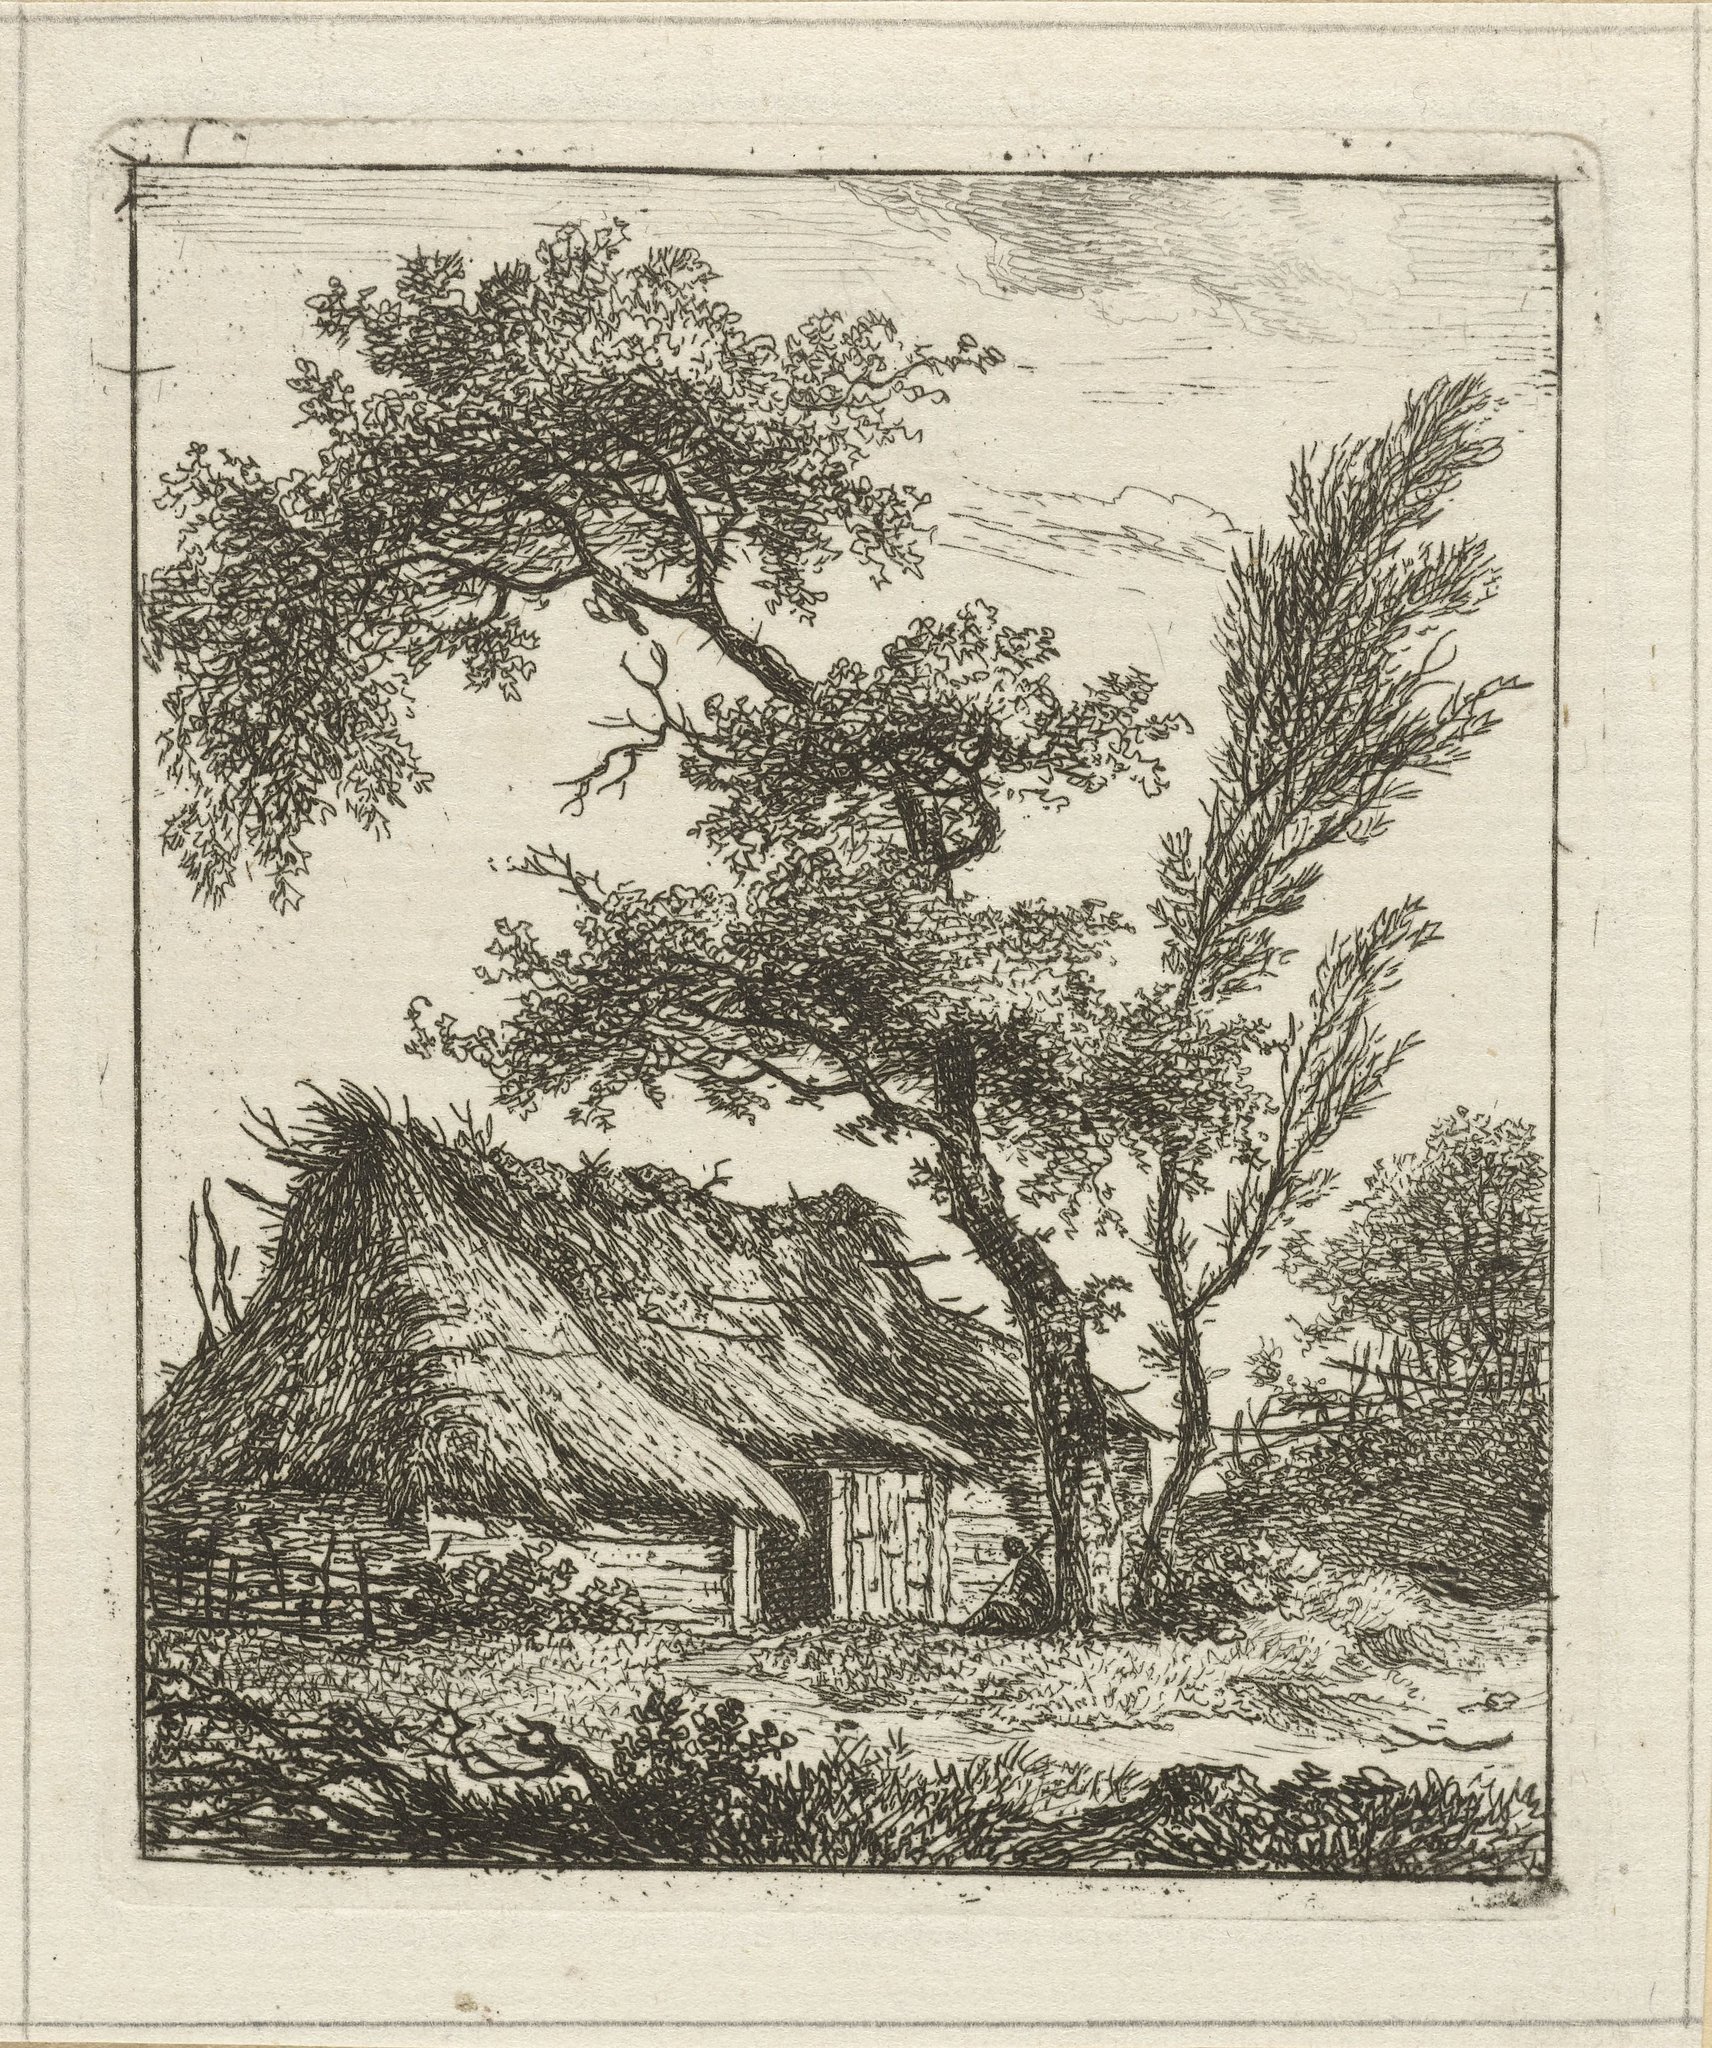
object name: print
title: Boerderij met rieten dak en twee bomen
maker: hermanus fock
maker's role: conservator, draughtsman, painter, print maker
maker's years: 1766-1822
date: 1781-1822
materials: paper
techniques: etching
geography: amsterdam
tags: farm or solitary house in landscape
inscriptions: collector's mark: Lugt 924, collector's mark: Lugt 2228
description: Gezicht op een boerderij met een rieten dak. Tegenover de deuropening zit een persoon tegen een hoge boom aan.